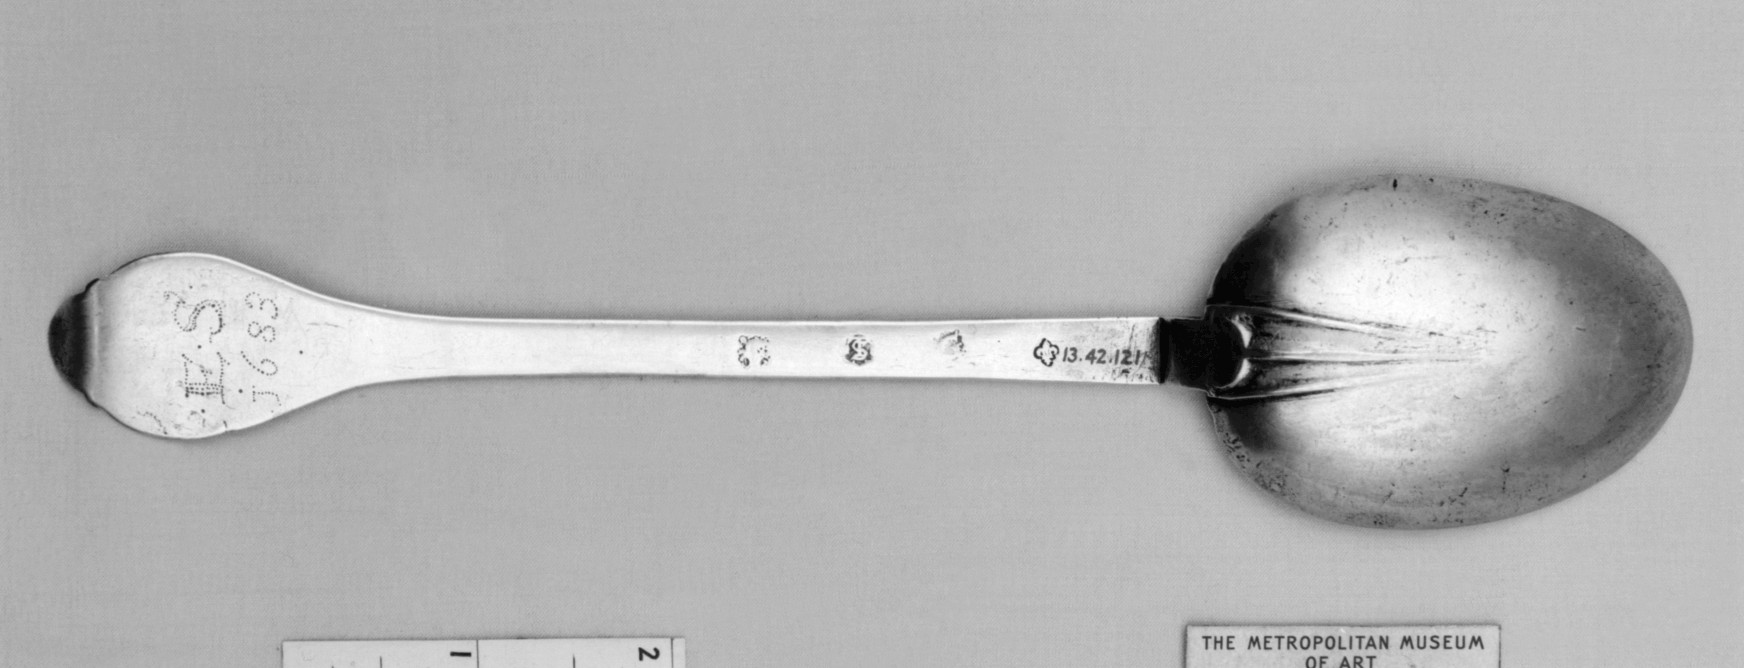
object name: spoon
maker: timothy skottowe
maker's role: maker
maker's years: 1600-1700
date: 1650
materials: silver